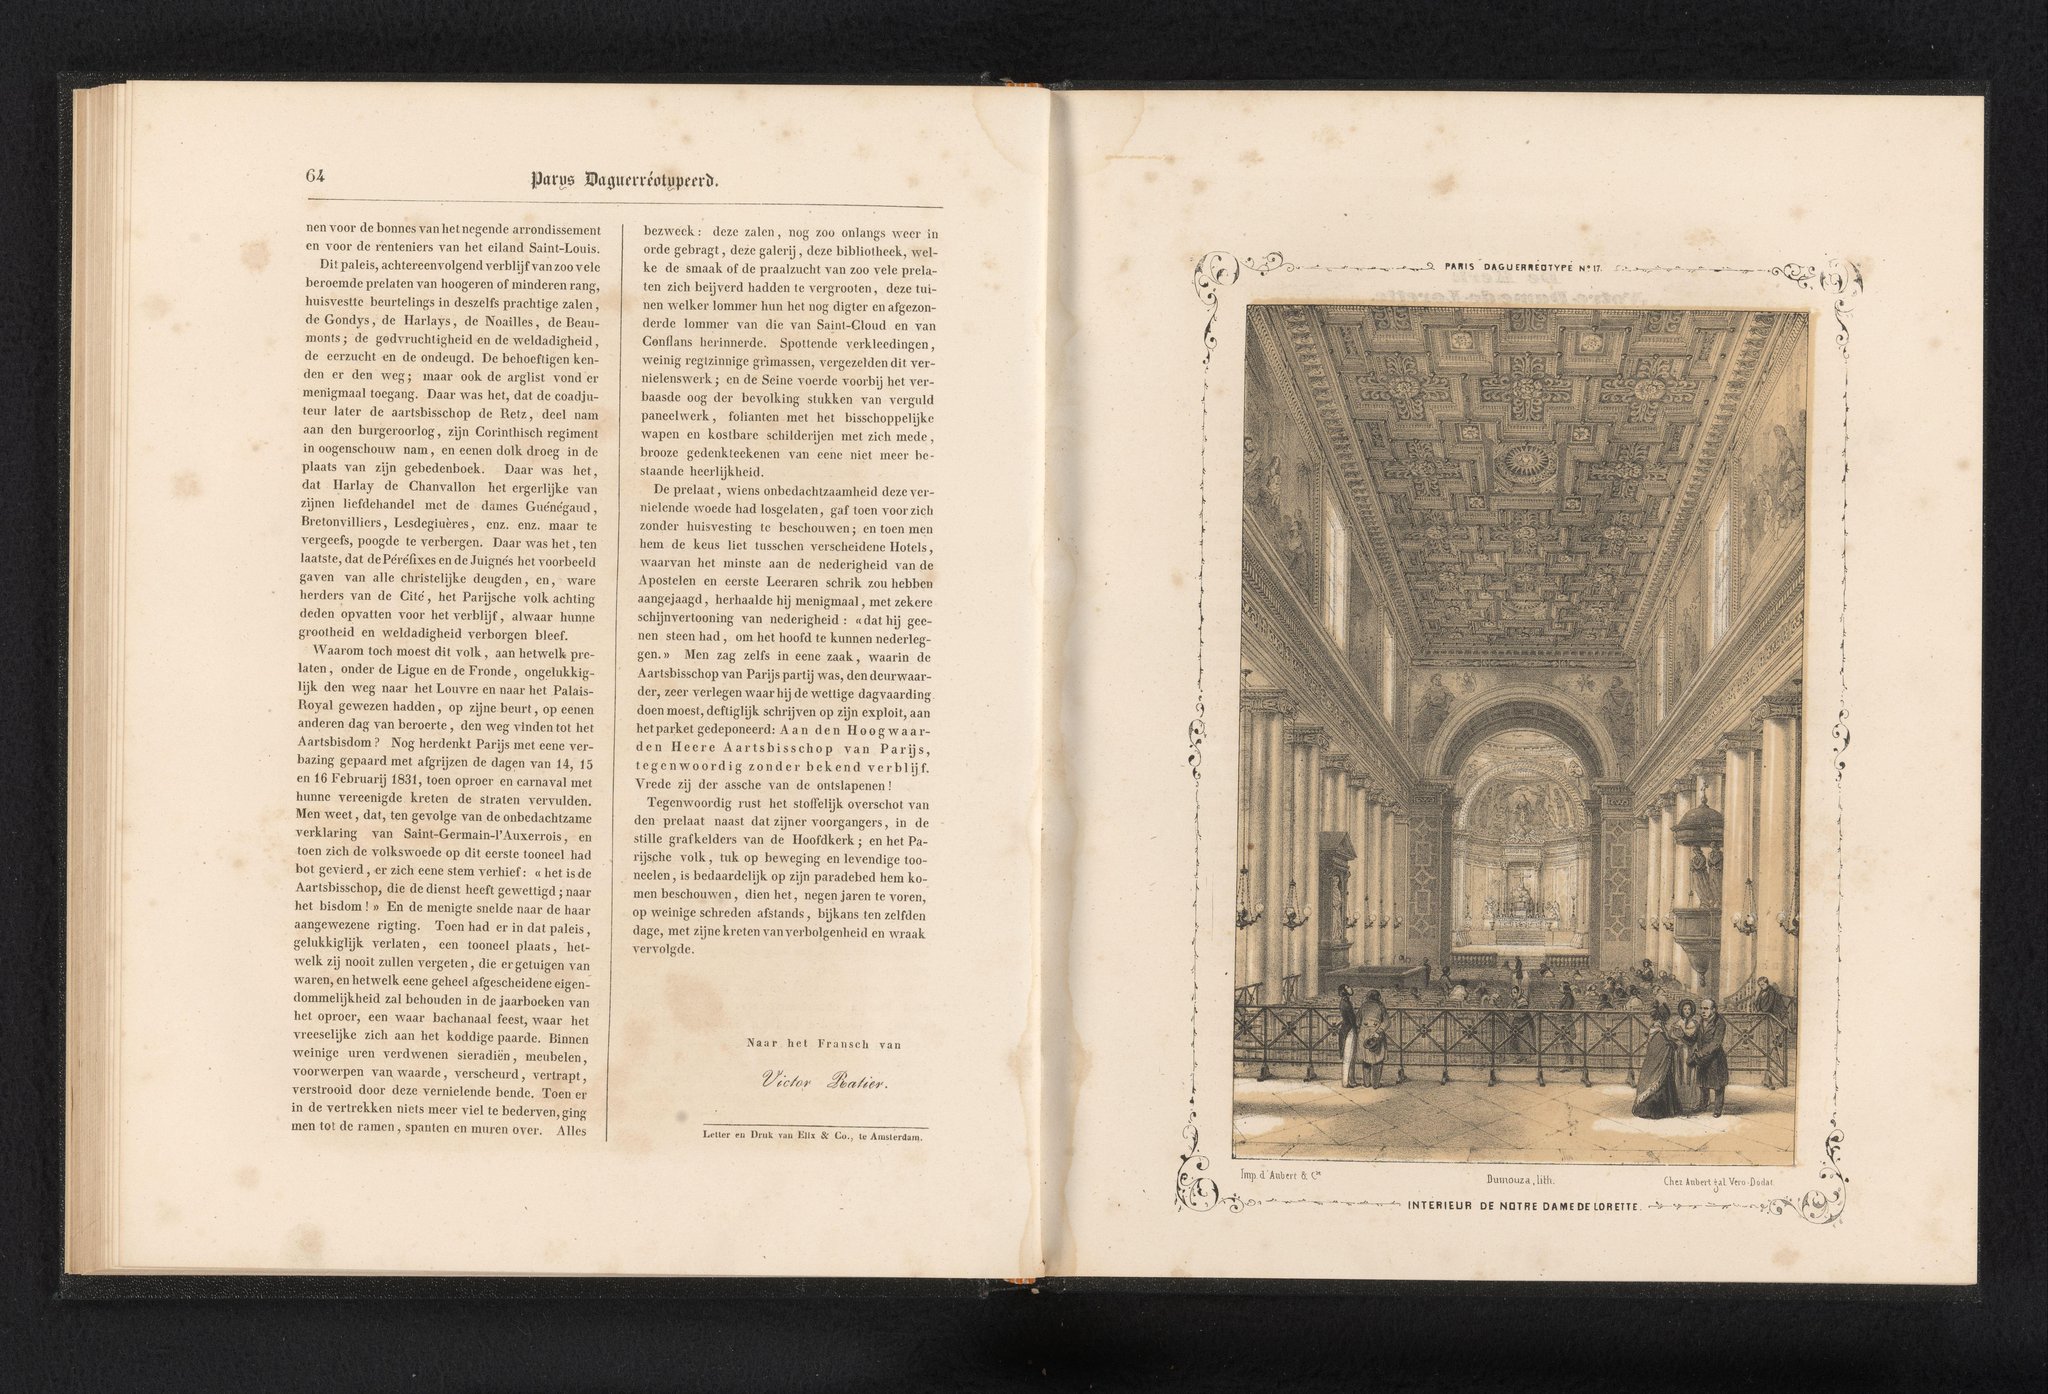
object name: page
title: Interieur van de Église Notre-Dame de Lorette in Parijs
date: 1839-1840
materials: paper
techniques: tone lithography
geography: paris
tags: interior of church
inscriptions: inscription: ‘PARIS DAGUERRÉOTYPÉ No. 17.’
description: Prent op vijfenzestigste ongenummerde pagina.